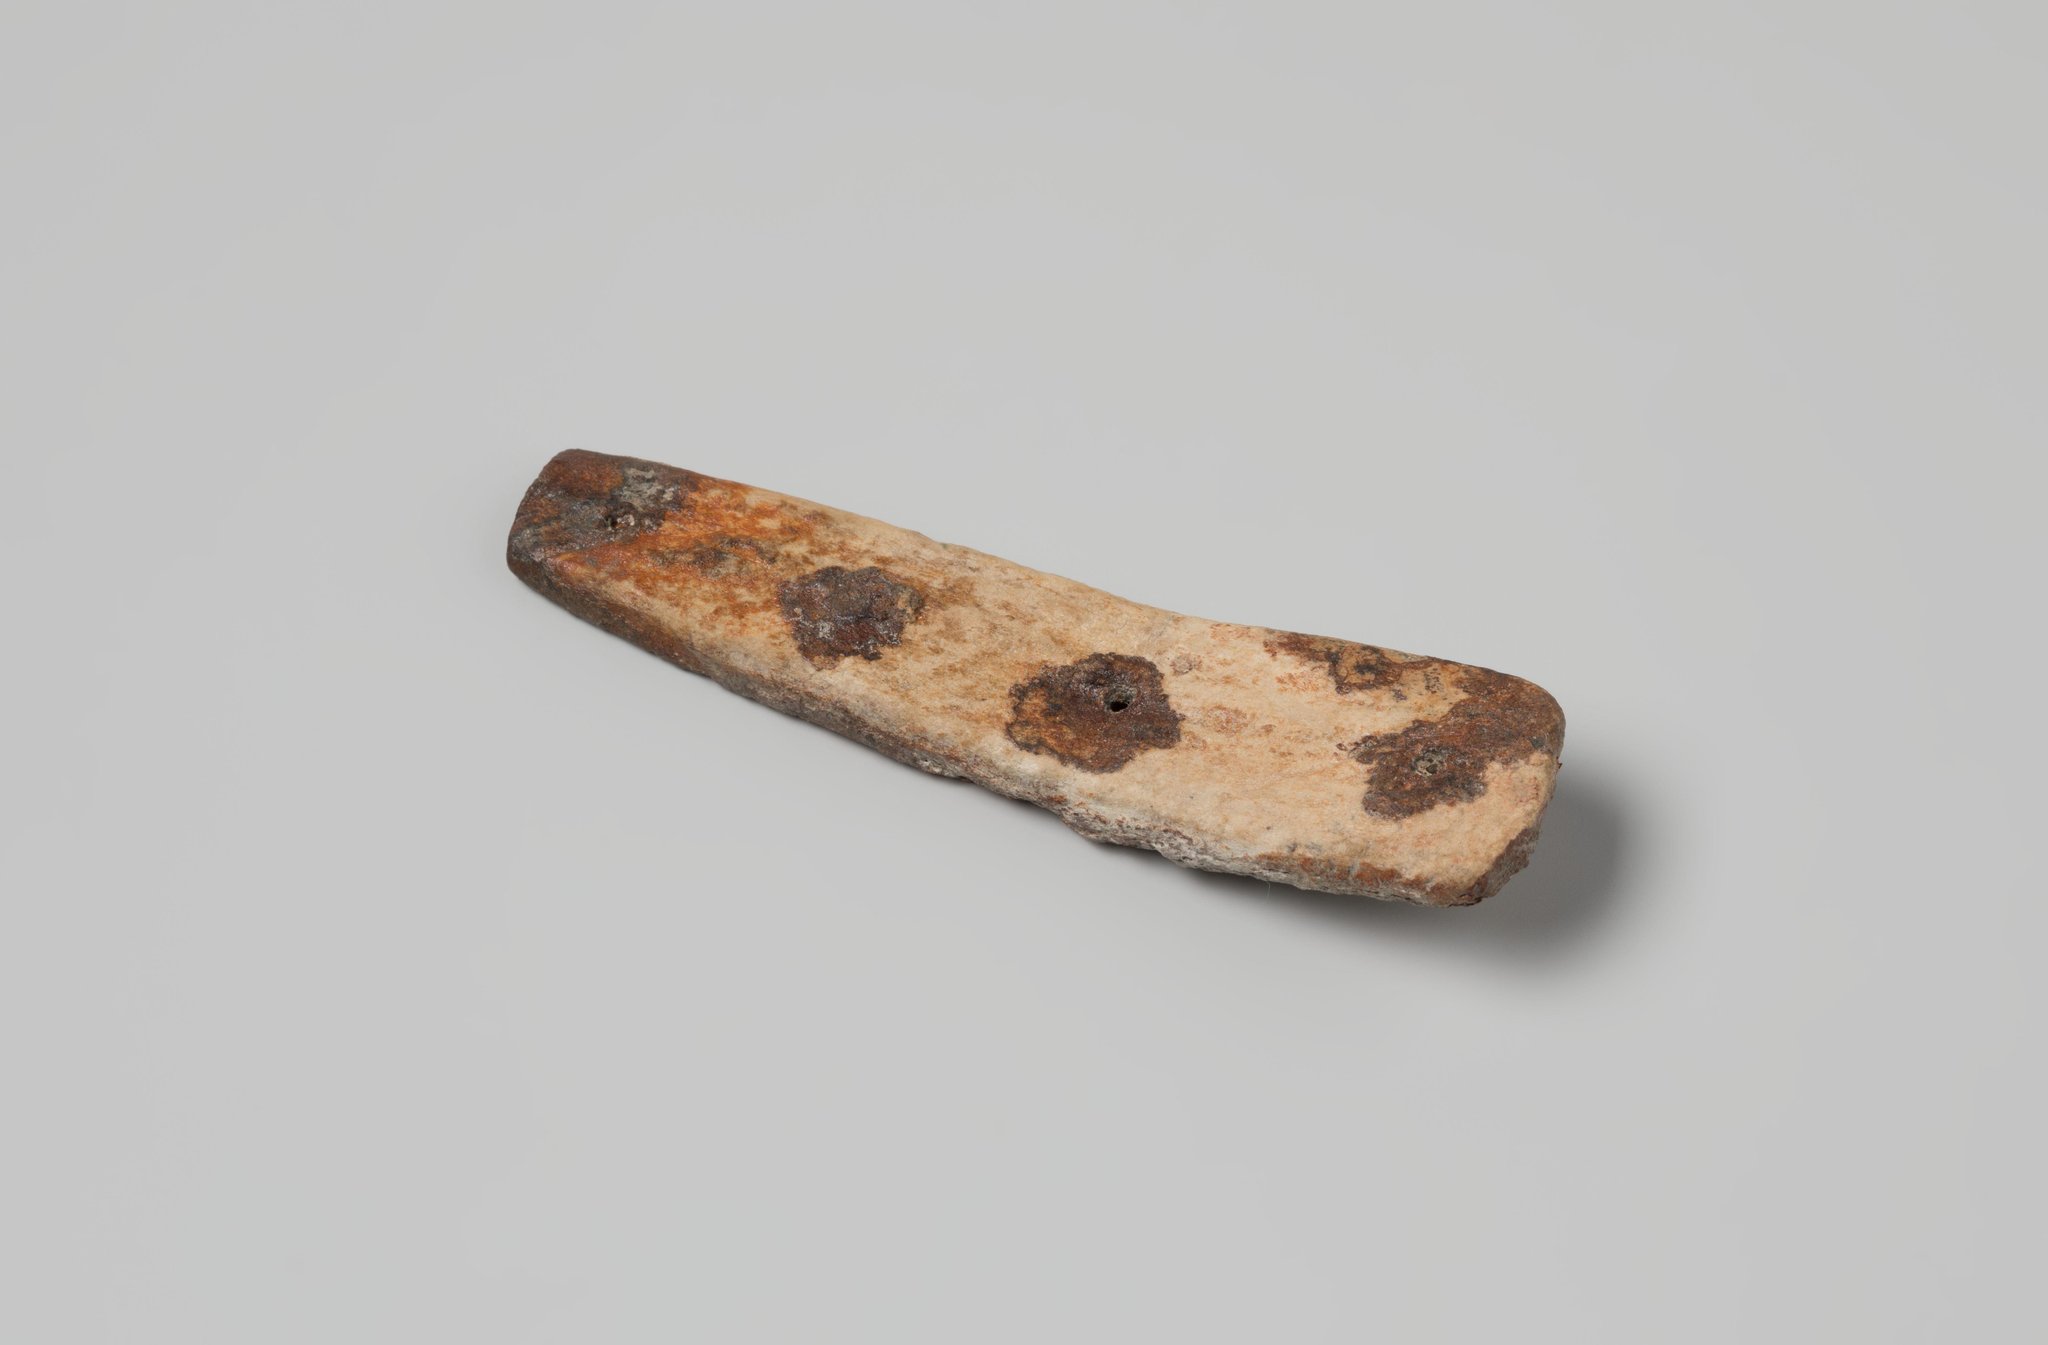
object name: knife handle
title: Messenheft uit het wrak van de Oost-Indiëvaarder Hollandia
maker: Anonymous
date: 1700-1743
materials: bone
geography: netherlands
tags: verenigde oostindische compagnie, hollandia (schip), annet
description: Knife-handle, tangplate; cracked, rel. NG 1980-27H1149, 4 rivet-holes.